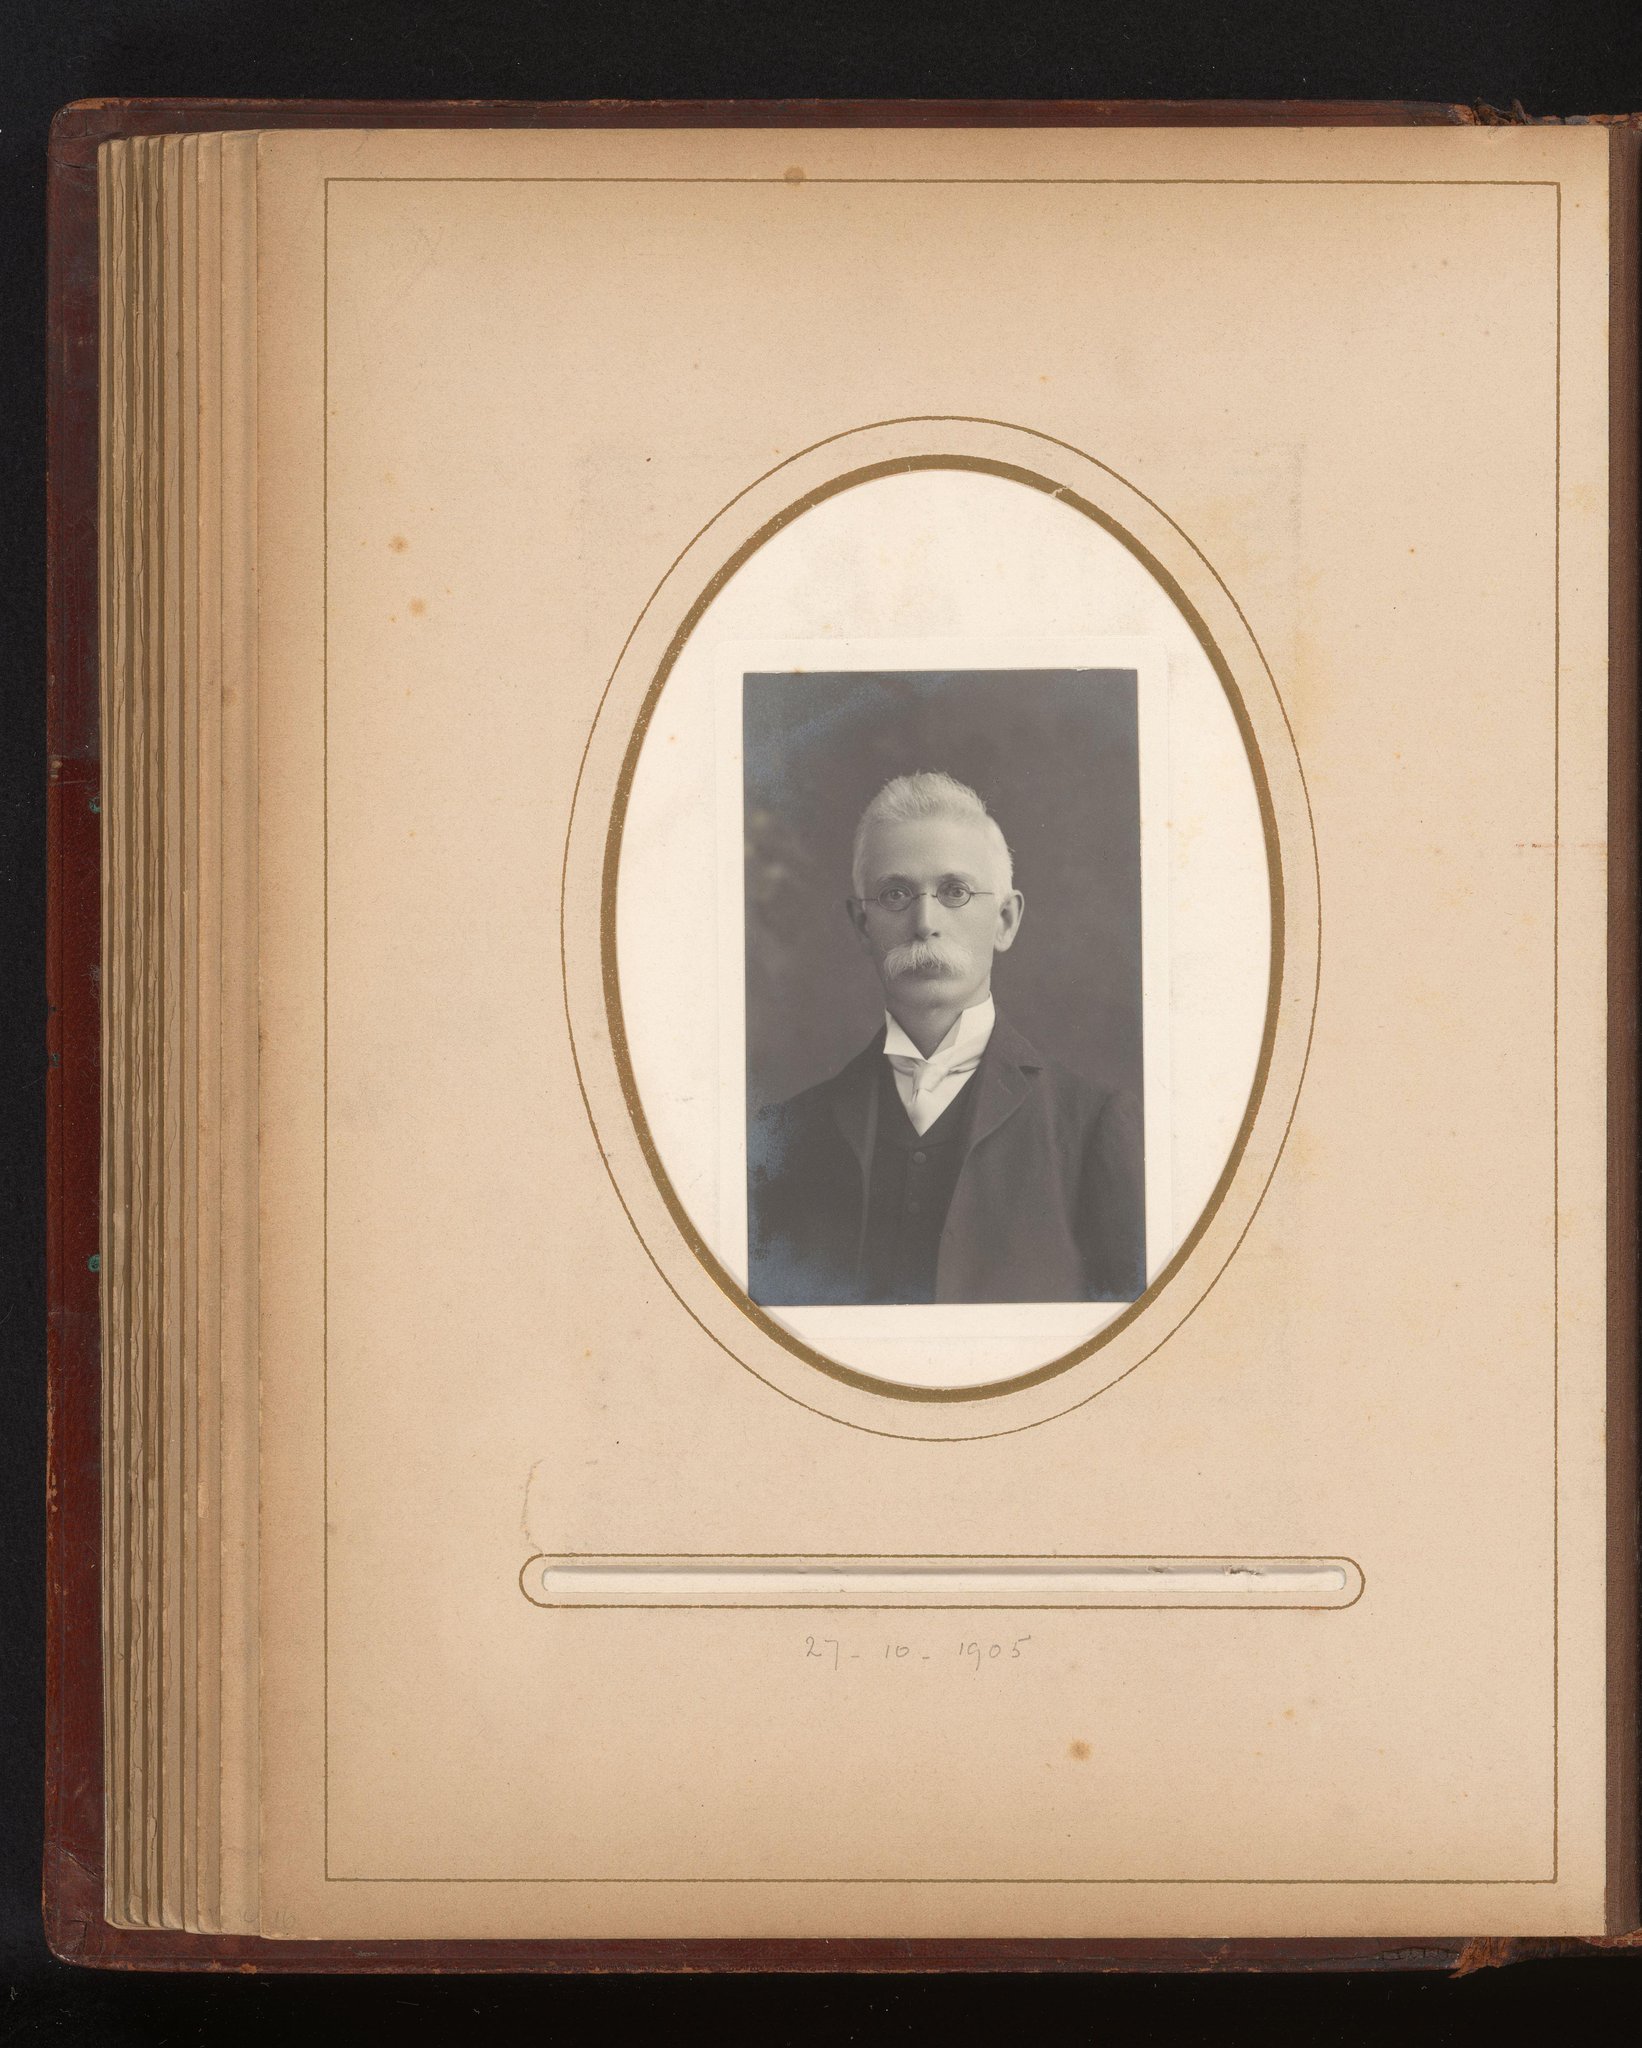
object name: cabinet photograph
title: Portret van een man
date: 1905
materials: cardboard, photographic support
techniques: gelatin silver print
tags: eyeglasses, spectacles, moustache, adult man, historical persons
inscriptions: annotation: ‘Sincerely yours/ J. Edwardson/ 27/10/05’